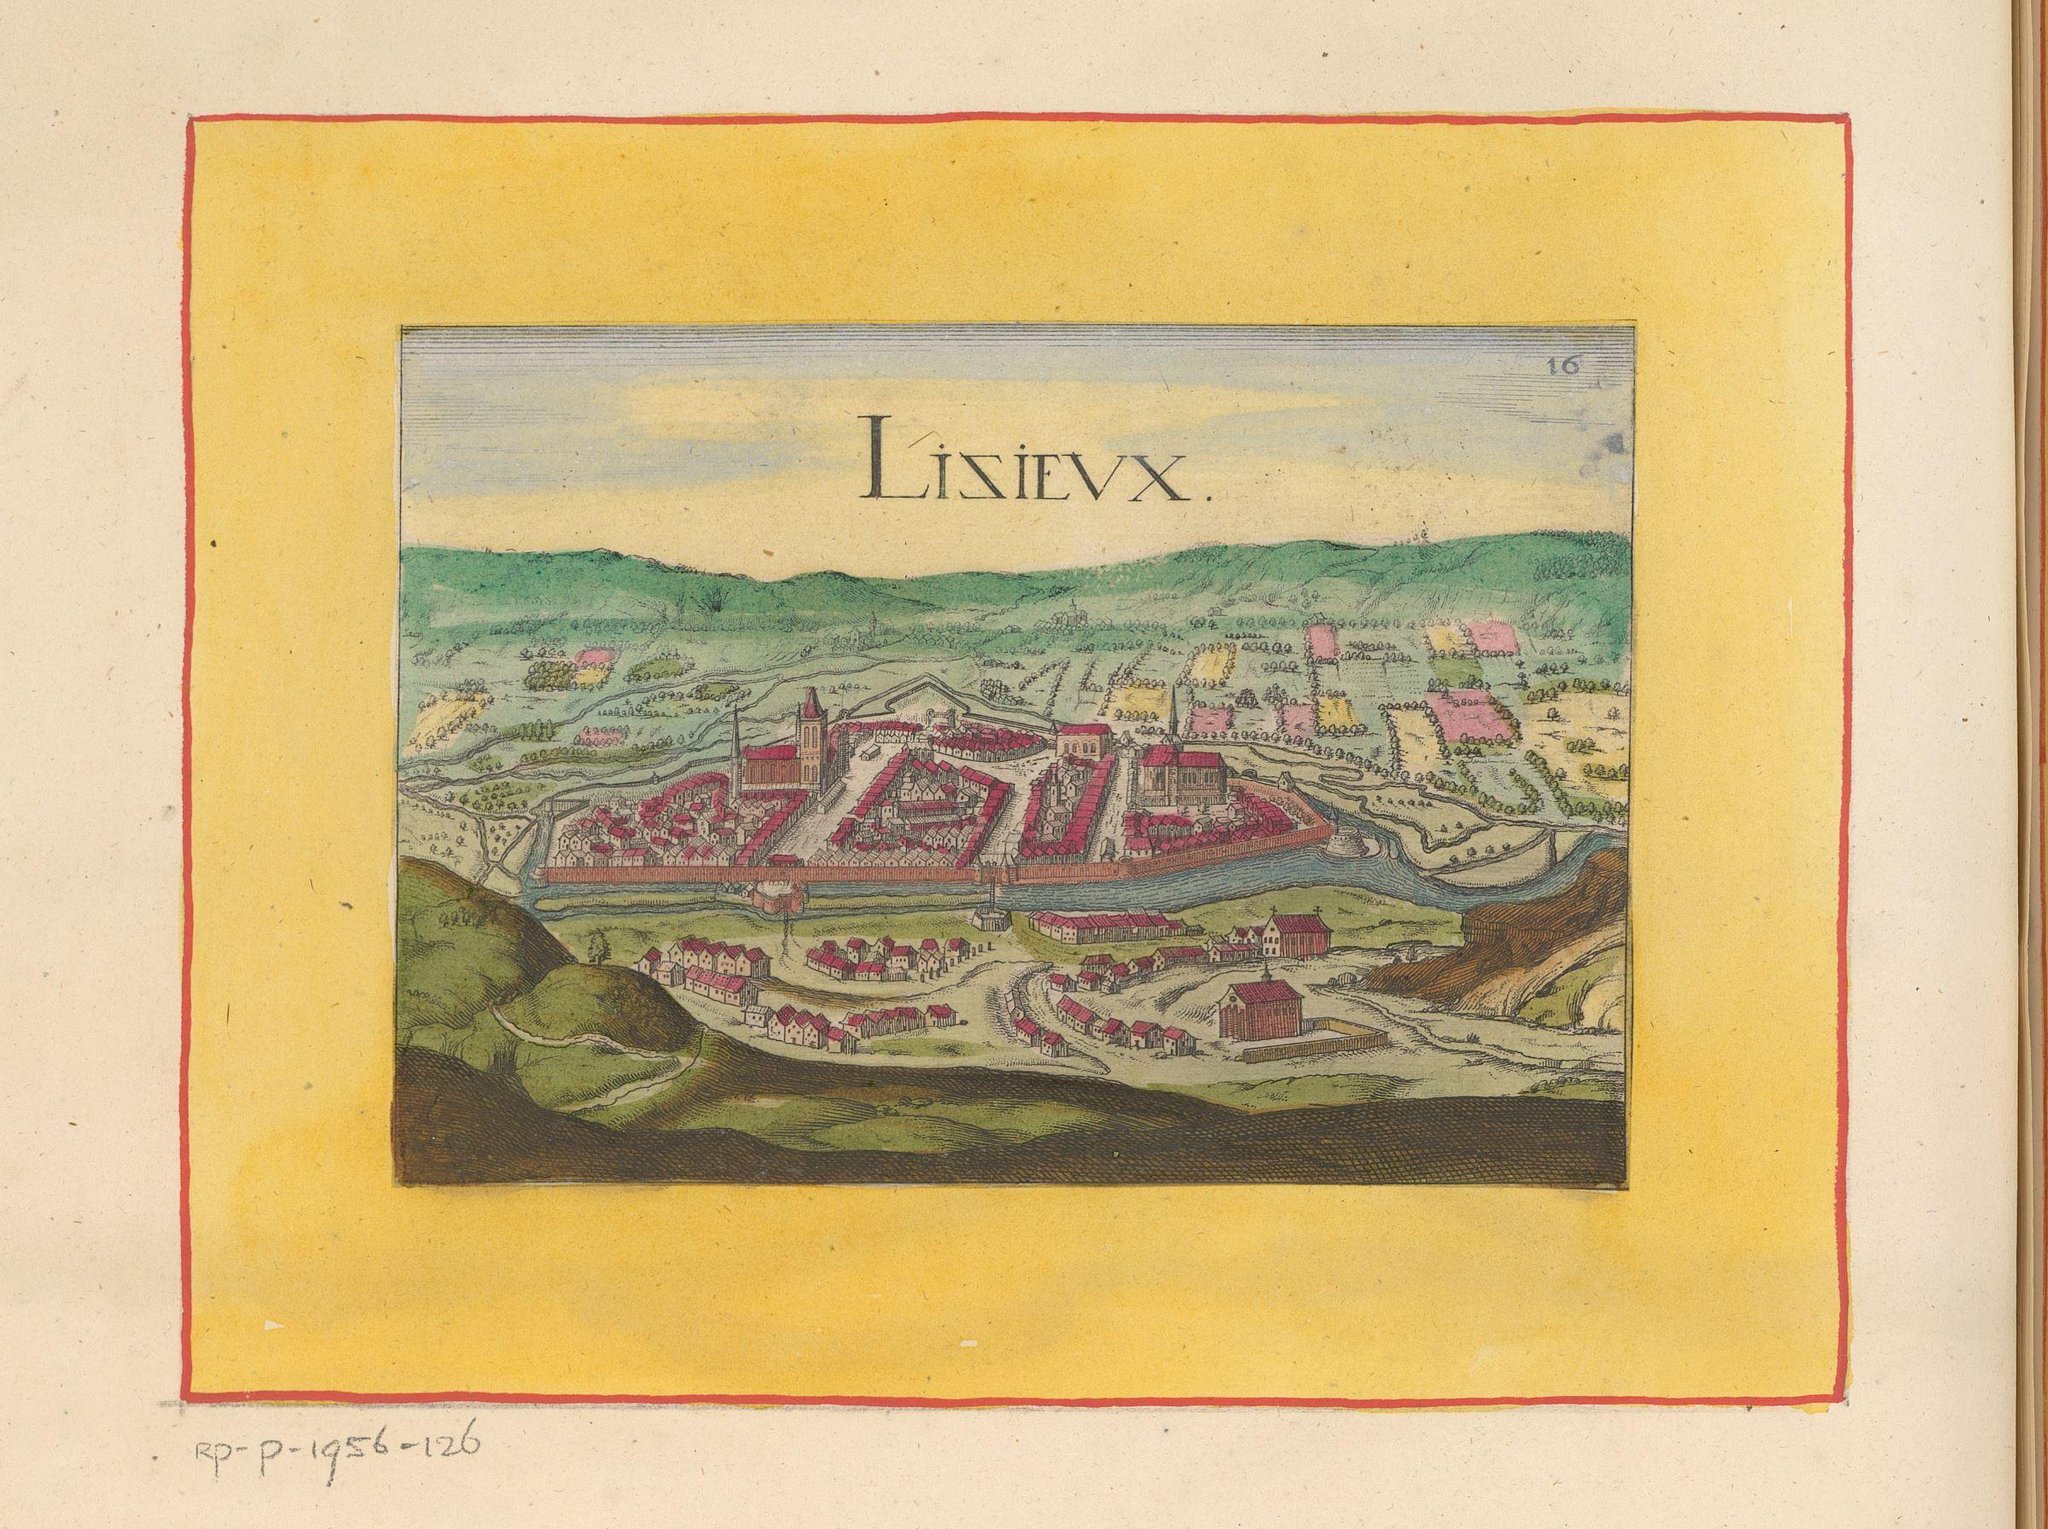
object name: print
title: Gezicht op Lisieux in vogelvluchtperspectief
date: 1638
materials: paper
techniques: engraving, etching, hand coloring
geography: paris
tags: village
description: Prent uit: Tassin, Christophe. Les plans et profils de toutes les principales villes et lieux considérables de France (...). Parijs: Michel van Lochom, 1638, kaart 16.